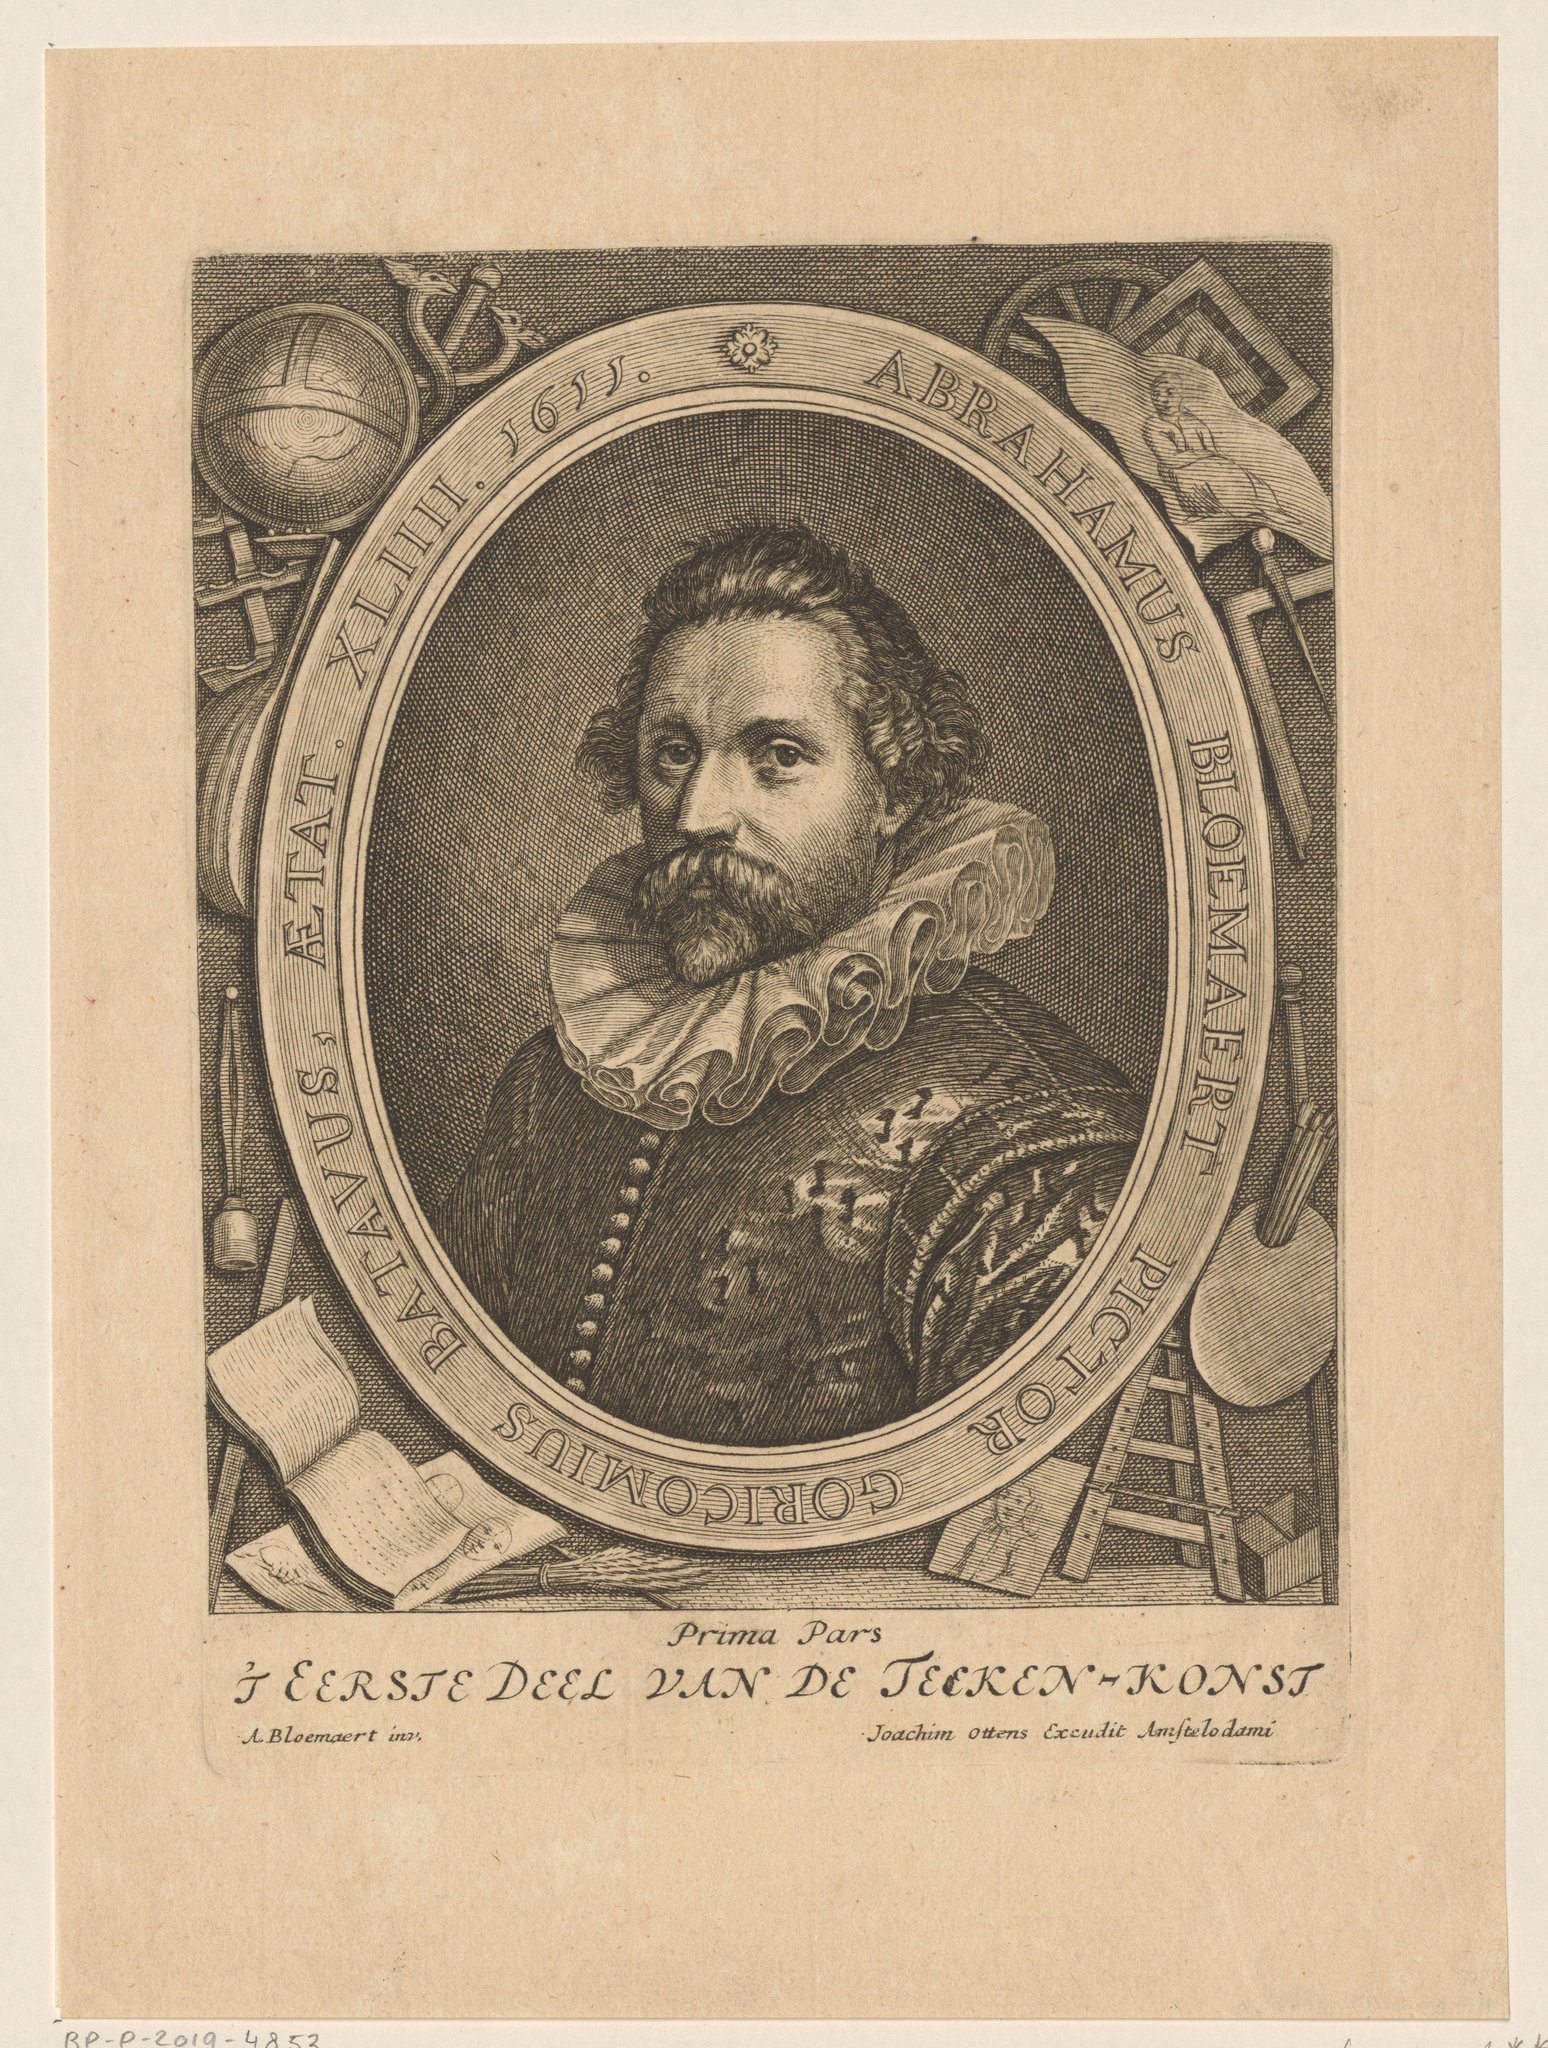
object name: print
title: Portret van Abraham Bloemaert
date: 1720-1725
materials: paper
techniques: engraving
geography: amsterdam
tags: utrecht, painter, print maker, draughtsman, abraham bloemaert, historical persons, portrait, self-portrait of painter, tools, implements of painter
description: Prent uit: Bloemaert, Abraham. Eerste beginselen der teken-kunst. Amsterdam: erven Joachim Ottens, [1720-1725], dl. 1.